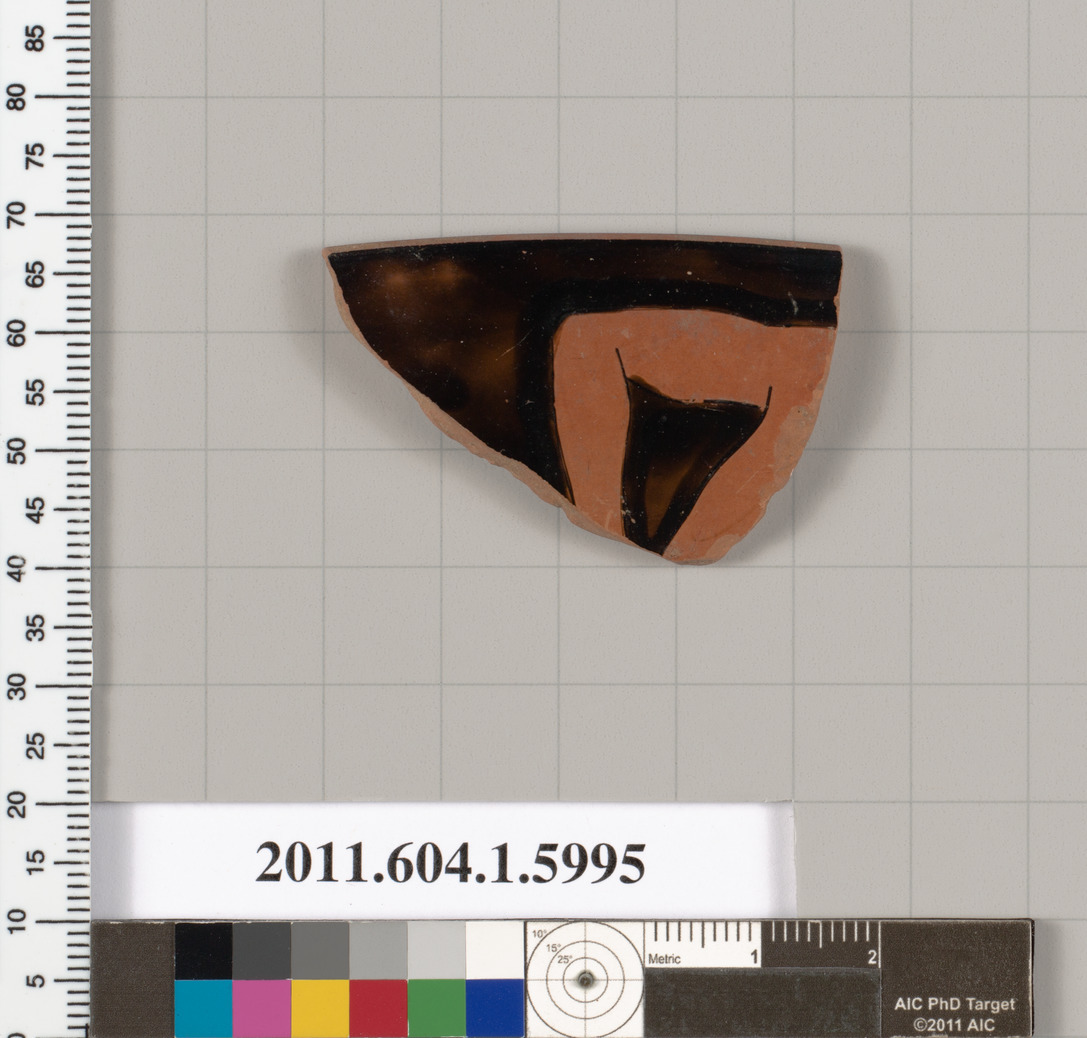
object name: kylix fragment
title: Terracotta rim fragment of a kylix (drinking cup)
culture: greek, attic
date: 510-500 BCE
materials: terracotta